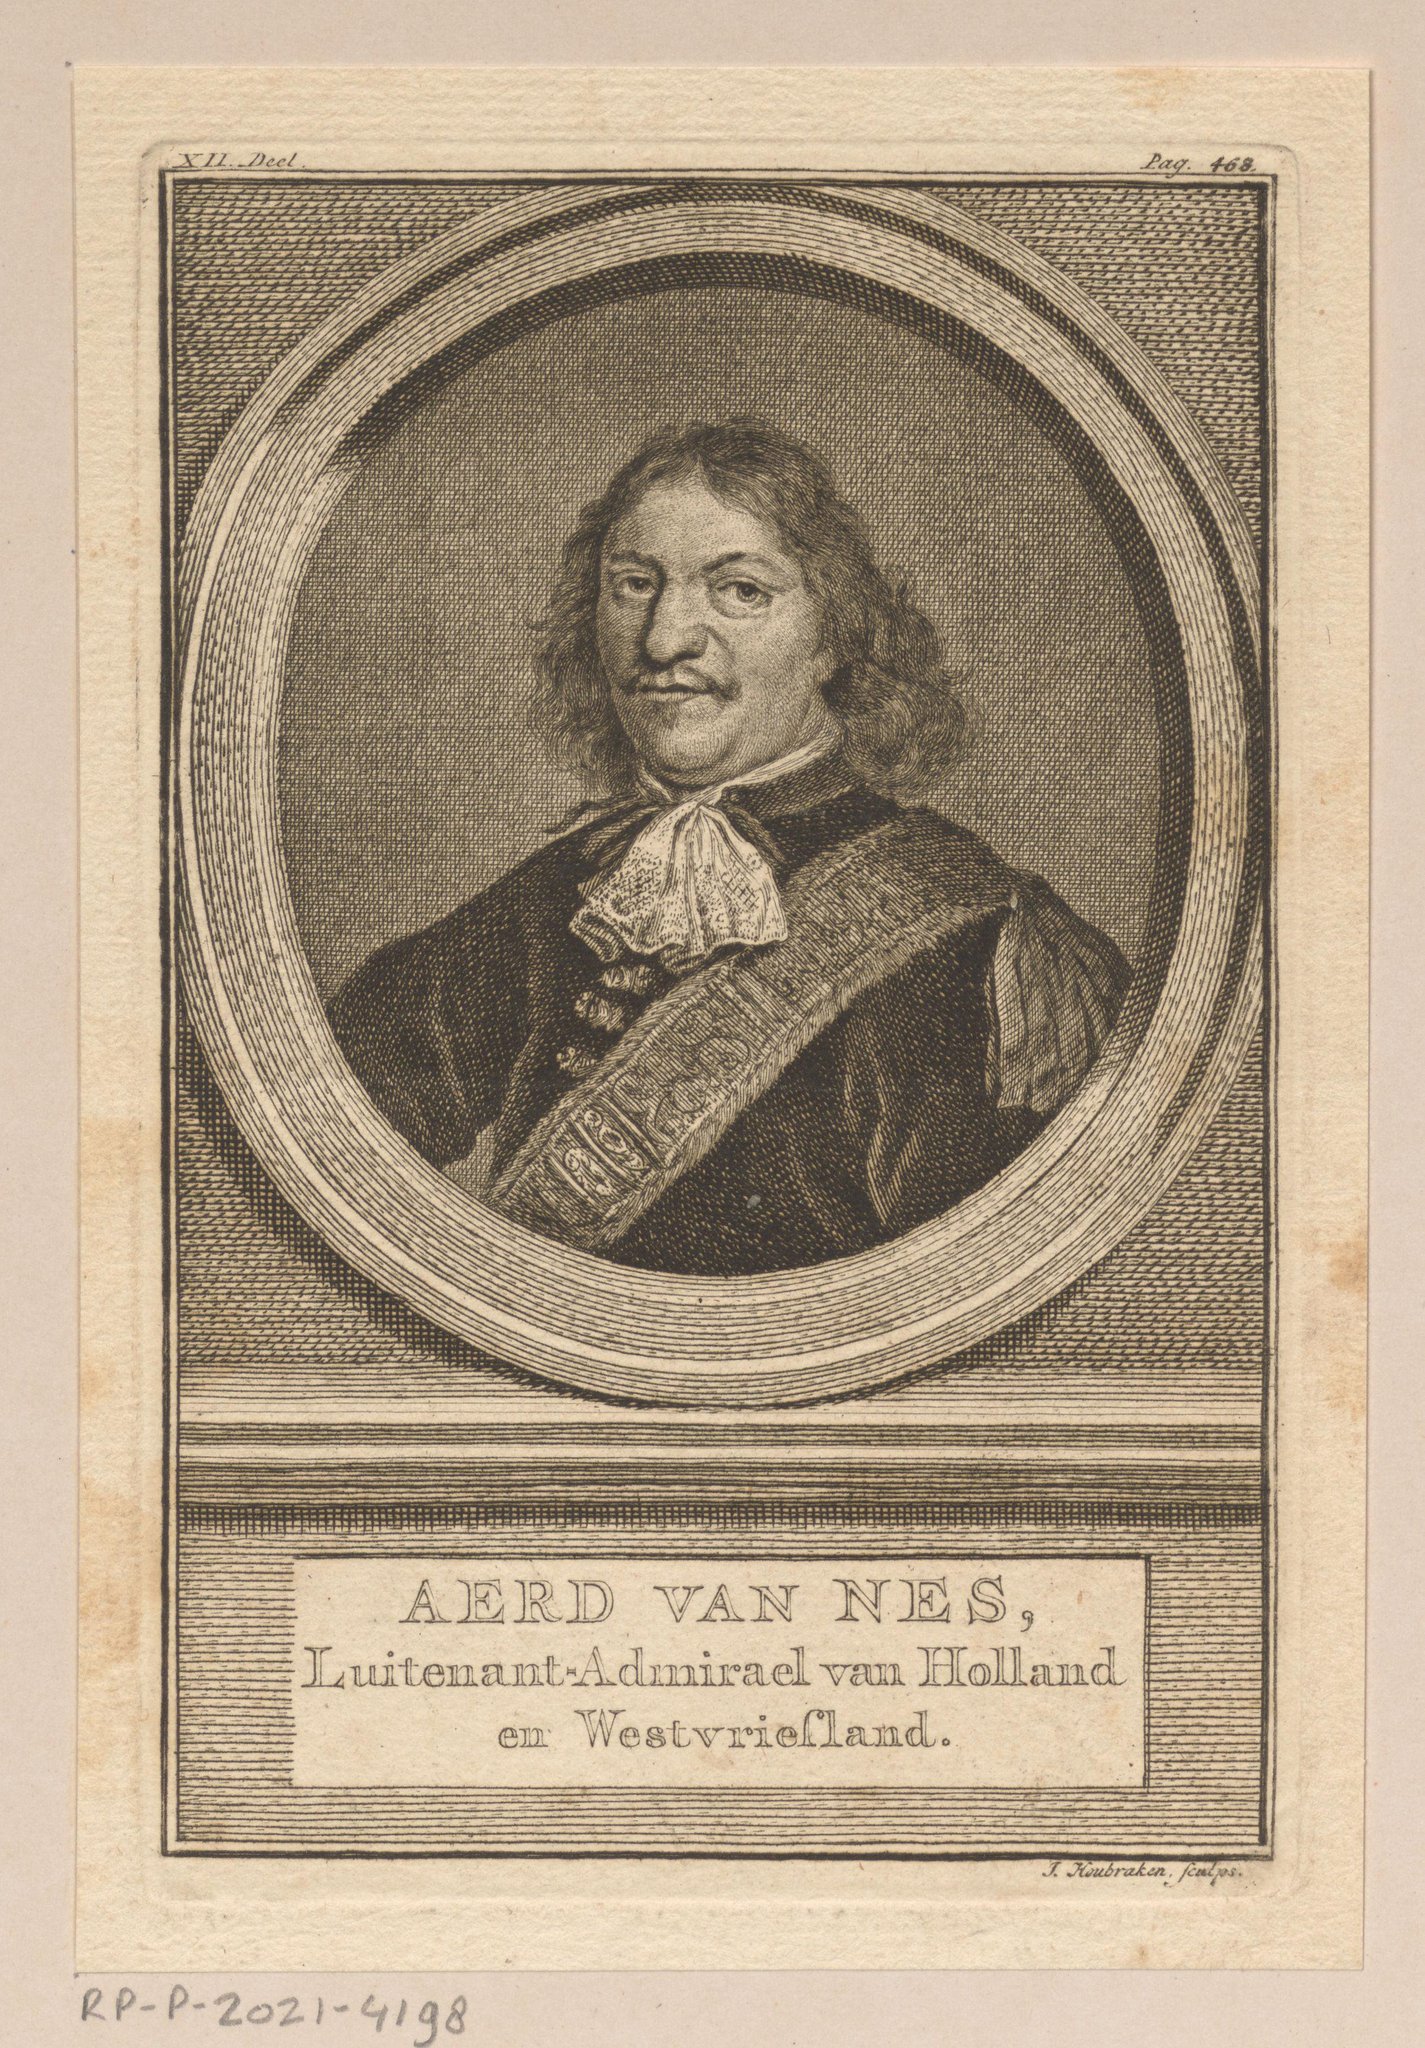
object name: print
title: Portret van Aert Jansz. van Nes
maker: jacob houbraken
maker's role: draughtsman, print maker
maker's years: 1698-1780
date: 1790-1796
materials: paper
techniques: engraving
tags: historical persons, commander-in-chief, admiral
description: Prent mogelijk uit: Wagenaar, Jan. Vaderlandsche historie, vervattende de geschiedenissen der nu Vereenigde Nederlanden, inzonderheid die van Holland (...). 21 dln. Amsterdam: Johannes Allart, 1790-1796.